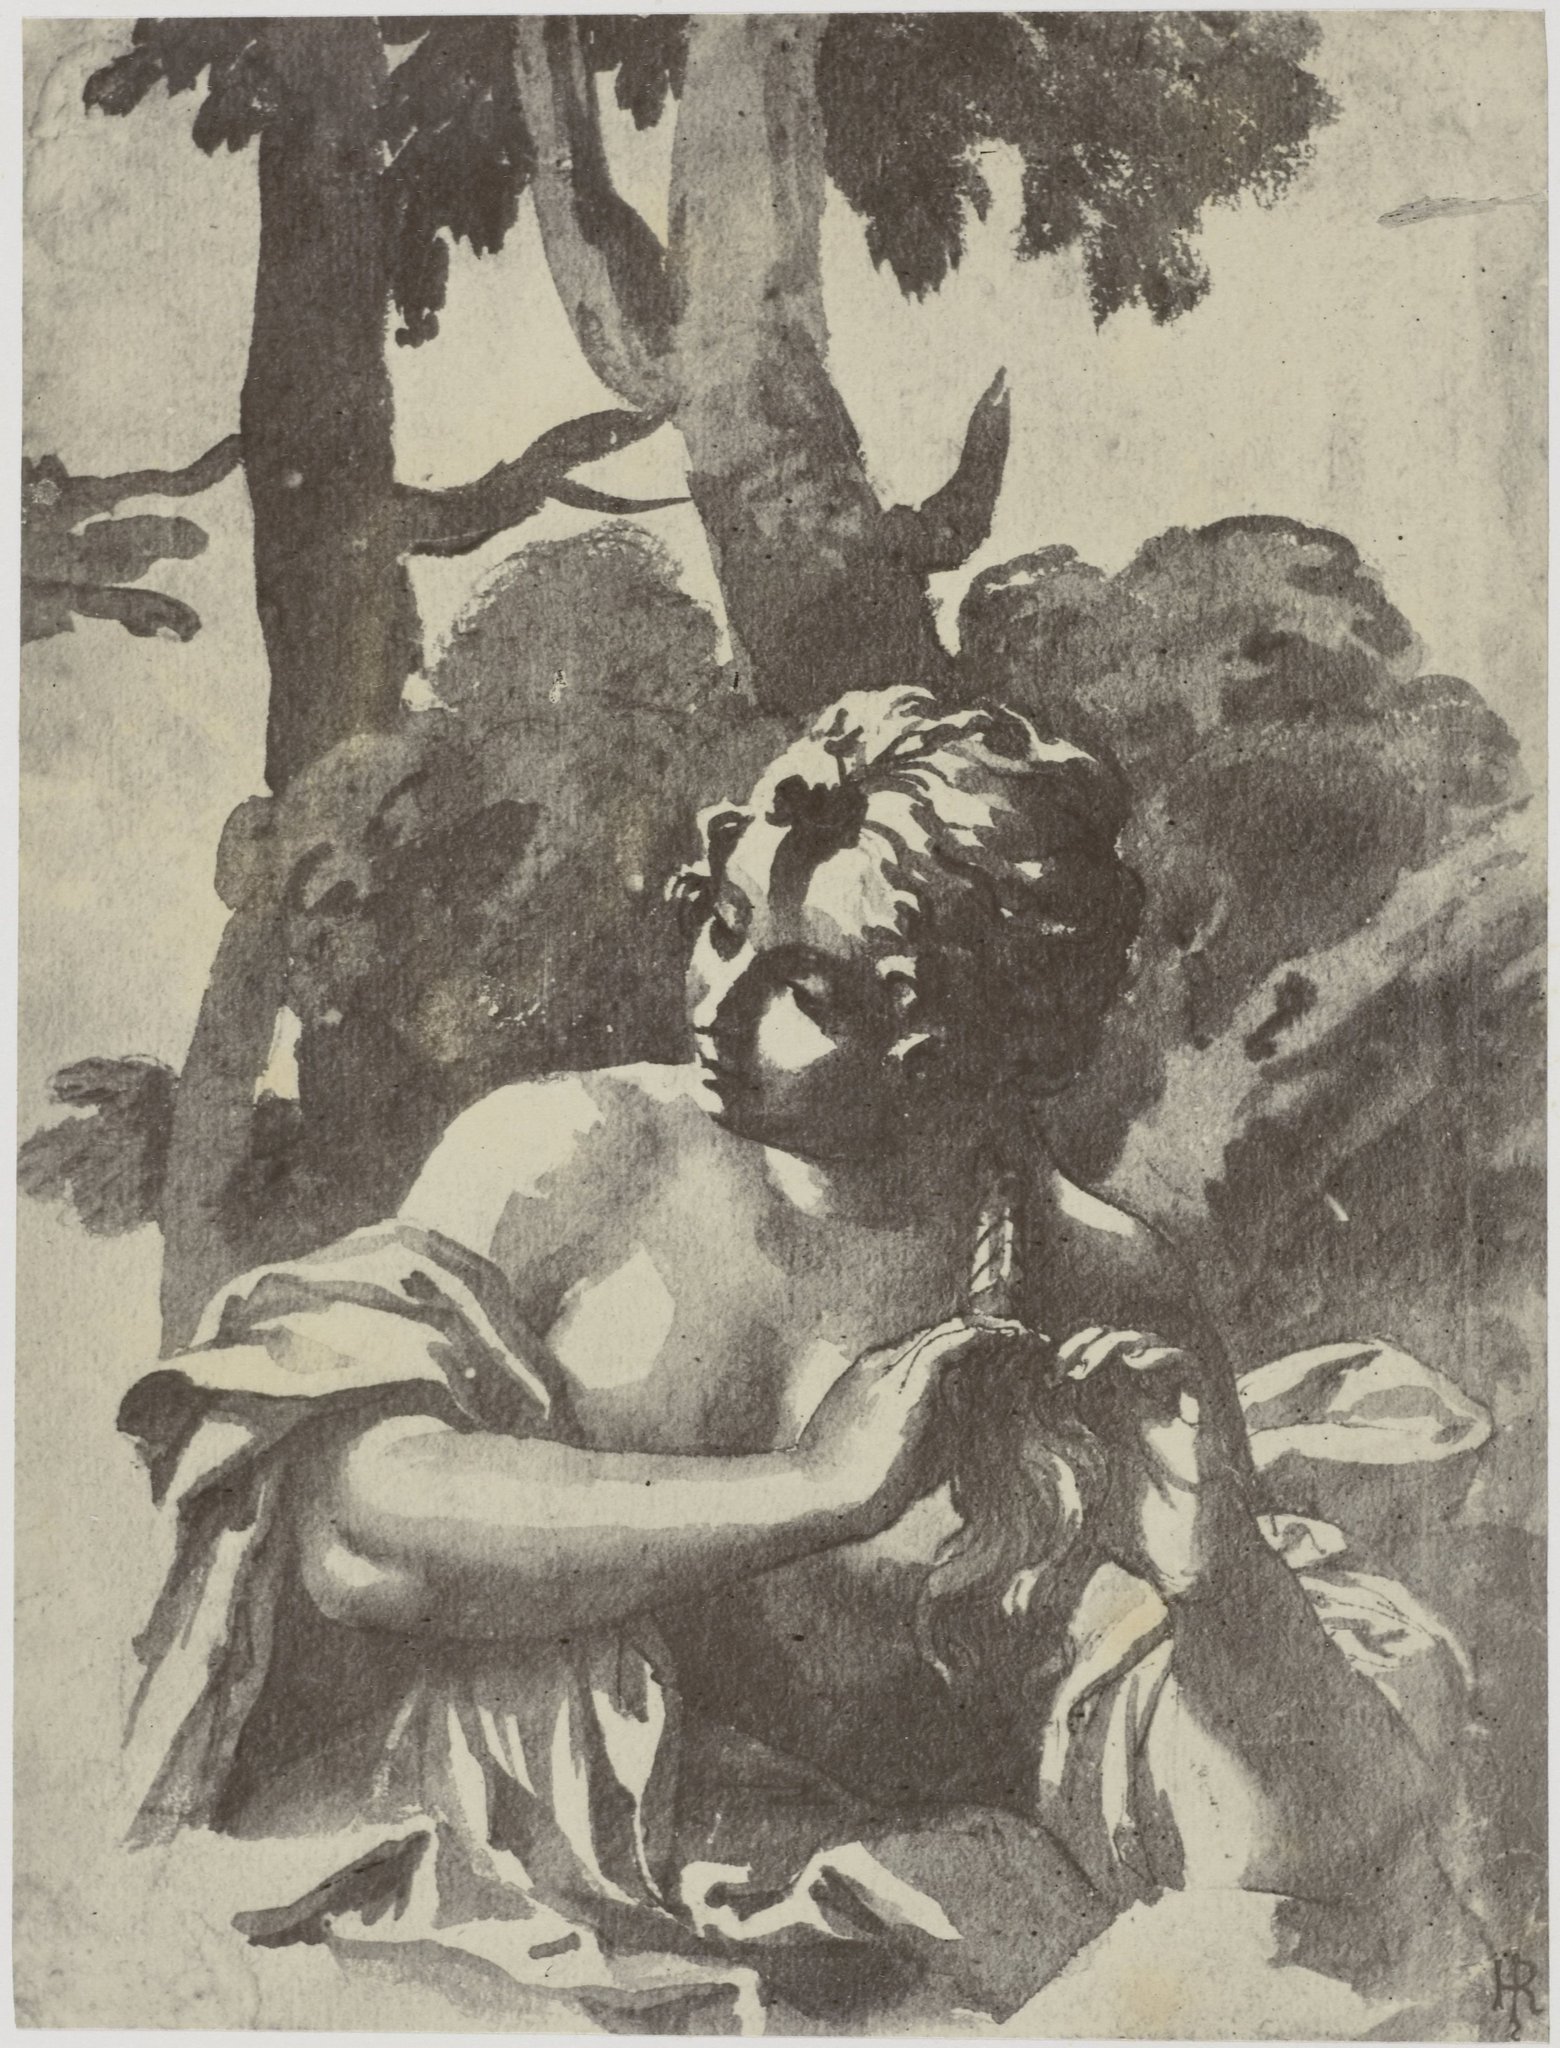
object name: photograph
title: Netscher, A Girl braiding her Hair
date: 1855-1858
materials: cardboard, paper, photographic support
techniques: albumen print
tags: drawing, sketch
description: Fotoreproductie van tekening in 'The Reveley Collection of Drawings at Brynygwin', afb. 30.